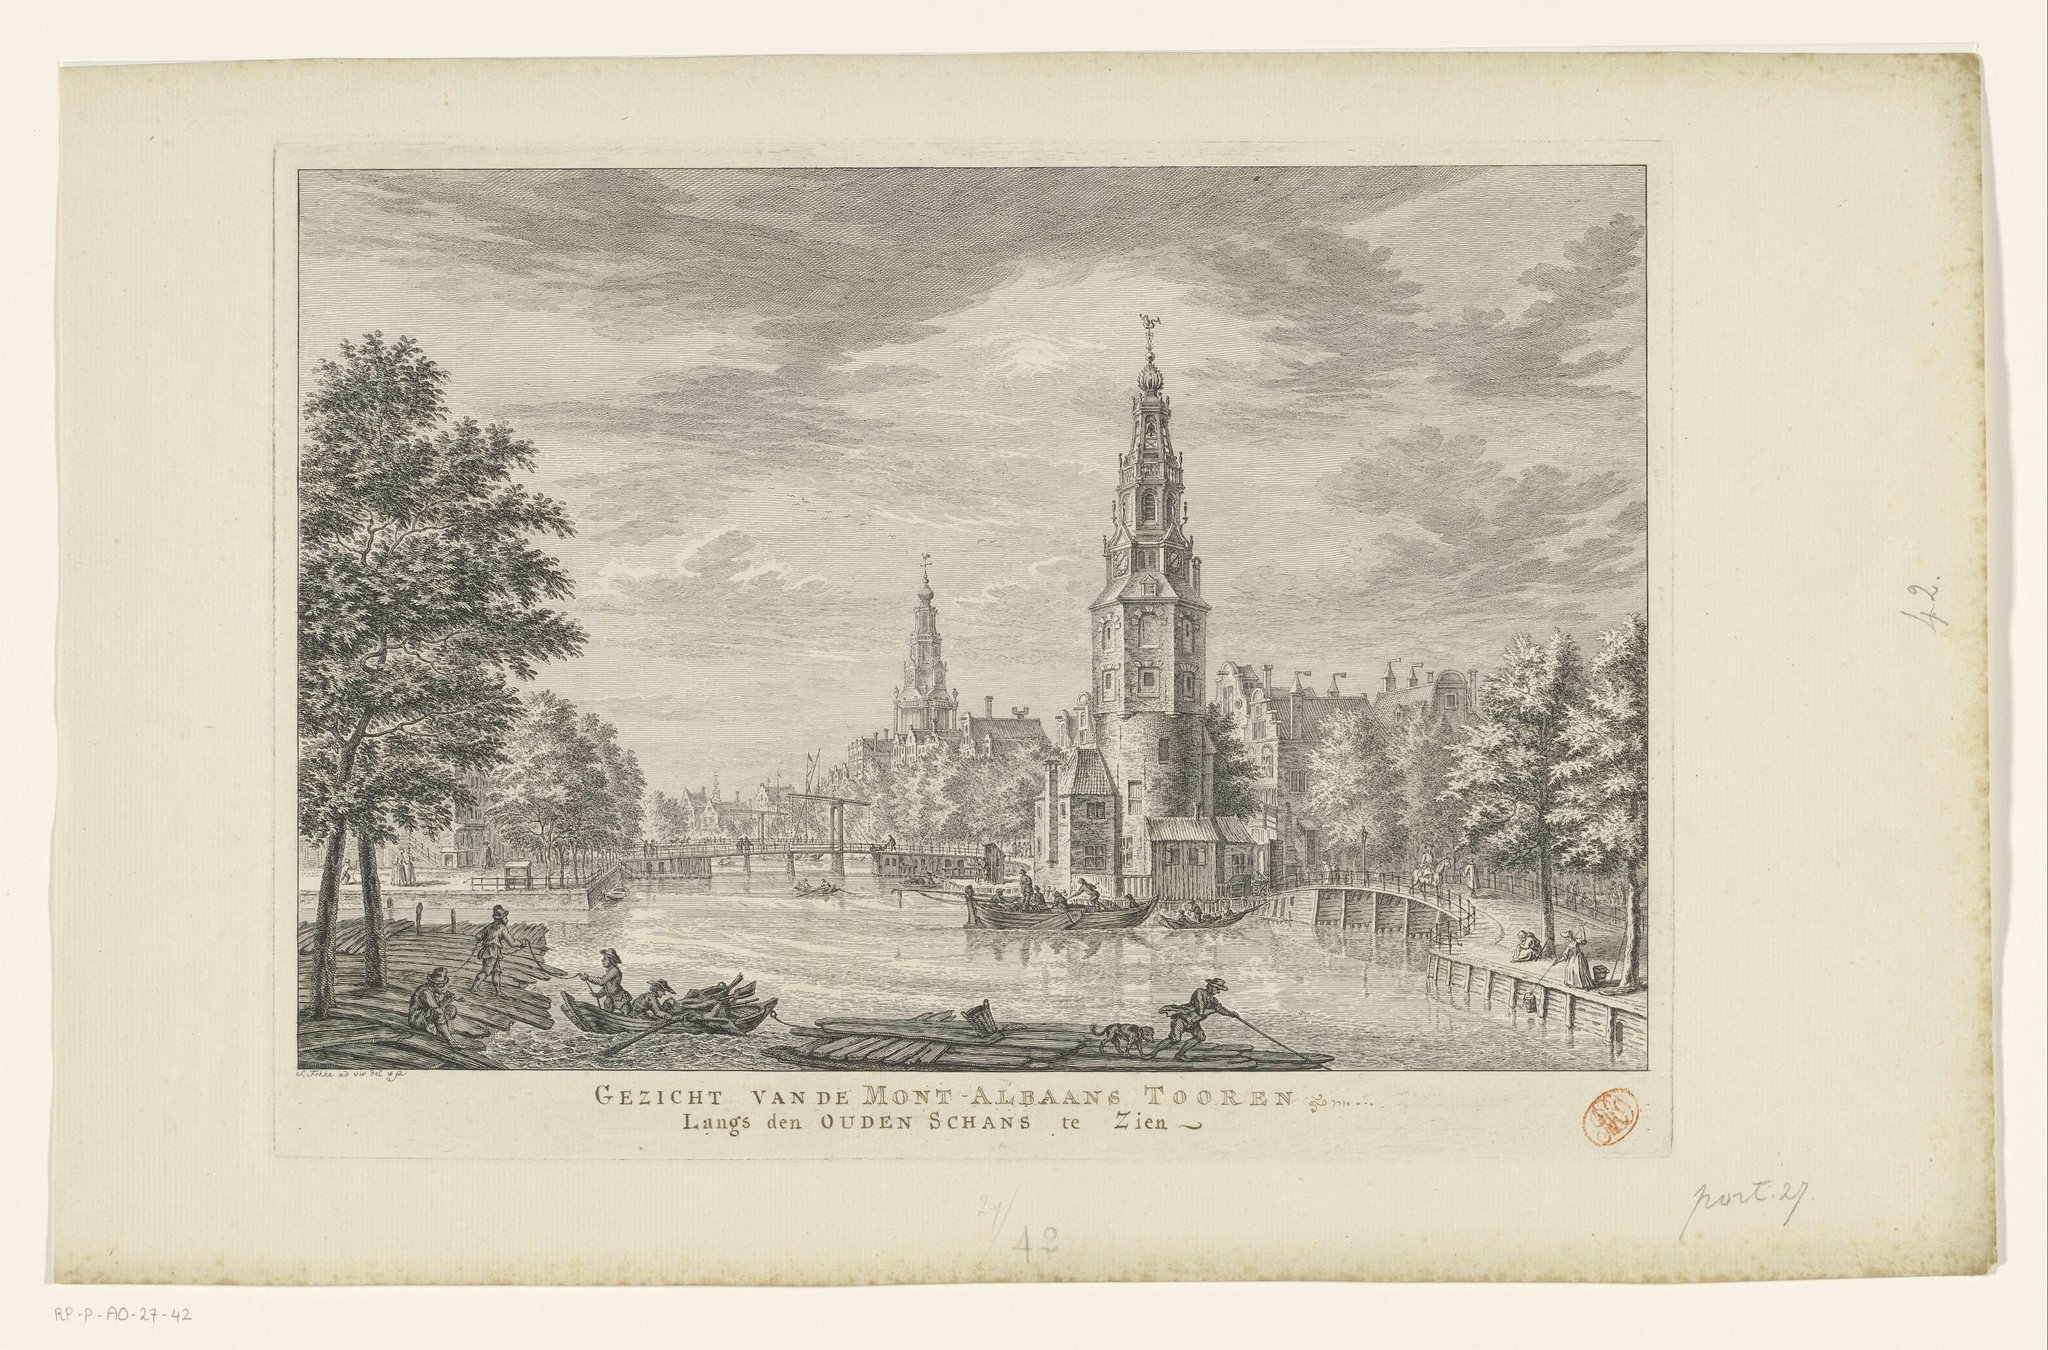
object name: print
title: Gezicht van de Mont-Albaans Tooren langs den Ouden Schans te zien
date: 1760-1783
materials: ink, paper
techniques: engraving, etching, pen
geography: amsterdam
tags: bridge in city across river, canal, etc. (+ city(-scape) with figures, staffage), tower, clock tower ~ monumental adornment, towers ~ fortified city, canals, waters (in city) (+ city(-scape) with figures, staffage), street (+ city(-scape) with figures, staffage), parts of church exterior and annexes: tower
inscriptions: collector's mark: Lugt 195, inscription: ‘Gezicht van de Mont-Albaans Tooren langs den Ouden Schans te zien’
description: Latere staat opgenomen in: Nieuwe atlas, van de voornaamste gebouwen en gezigten der stad Amsterdam, met derzelver beknopte beschryvingen, 2 dln. Amsterdam: Daniel Jean Changuion en Petrus van Hengst, 1783.Latere staten van deze prent zijn ook gebruikt in de zogenaamde Atlas van Fouquet.* Pierre Fouquet gaf vanaf 1760 stadsgezichten van Amsterdam - naar tekeningen van verschillende kunstenaars, gemaakt door verschillende prentmakers - uit. Deze prenten werden aanvankelijk los of in series verkocht. Zoals toen gebruikelijk kon de koper de prenten zelf laten inbinden. Hiertoe gaf Fouquet tussen 1778 en 1783 een titelblad, plattegrond en inhoudsopgave van de tot dusver 100 uitgegeven prenten uit (1). Gezien de inhoud afhankelijk was van wat de koper had verzameld verschilt de inhoud van de verschillende bewaarde Fouquetatlassen onder deze titel sterk. Ook zijn er exemplaren bekend waar tevens andere prenten aan zijn toegevoegd. Omdat er behoefte bleek aan uitleg bij de platen werd in 1783 een nieuwe versie van de atlas uitgegeven, aangevuld met tekst en twee prenten. De aangegeven volgorde veranderde maar de platen van de al eerder uitgegeven prenten bleven ongewijzigd. Deze uitgave werd in opdracht van Fouquet gedrukt bij Daniël Jean Changuion en Petrus den Hengst (2). Een tiental platen werd bijgewerkt en verscheen, met nieuw impressum, in het vervolg van Wagenaars geschiedenis van Amsterdam, uitgeven door Petrus Conradi en Folkert van der Plaats (3). Een aantal jaar na het overlijden van Fouquet kwam Evert Maaskamp met een nieuwe uitgave van de atlas, met verbeterde tekst en toevoeging van twee prenten. Op alle platen verwijderde hij het oude en liet hij zijn eigen impressum zetten (4). * Onder de Atlas van Fouquet of Fouquetatlas verstaan we de hieronder vermelde publicaties (1), (2) en (4). (1). Afbeeldingen van de wyd-vermaarde koopstad Amsterdam benevens des zelvs voornaamste gebouwen en gezigten alle naar het leeven getekend / Receuil des edifices les plus considerables et des plus belles vues, de la fameuse ville d'Amsterdam, dessinées d'après nature. Amsterdam: Pierre Fouquet, 1778-1783. (2). Nieuwe atlas, van de voornaamste gebouwen en gezigten der stad Amsterdam, met derzelver beknopte beschryvingen. 2 delen. Amsterdam: Daniël Jean Changuion en Petrus den Hengst [in opdracht van Pierre Fouquet], 1783. (3). Stijl, Simon. Amsterdam, in zyne geschiedenissen, voorregten, koophandel, gebouwen, kerkenstaat, schoolen, schutterye, gilden en regeeringe, beschreeven. Om te dienen ten vervolge op het werk van Jan Wagenaar (…). 10 delen. Amsterdam en Harlingen: Petrus Conradi en Folkert van der Plaats, 1788-1801. (4). Nieuwe atlas, van de voornaamste gebouwen en gezigten der stad Amsterdam. Met derzelver beknopte beschryvingen. Amsterdam: Evert Maaskamp, 1805. * Het aantal vermelde staten is gebaseerd op het aantal gevonden staten. Mogelijk zijn er meer staten van deze prent. Zie ook RP-P-1903-A-23915 voor eerste bekende staat. Zie RP-P-1905-404 voor tweede bekende staat.